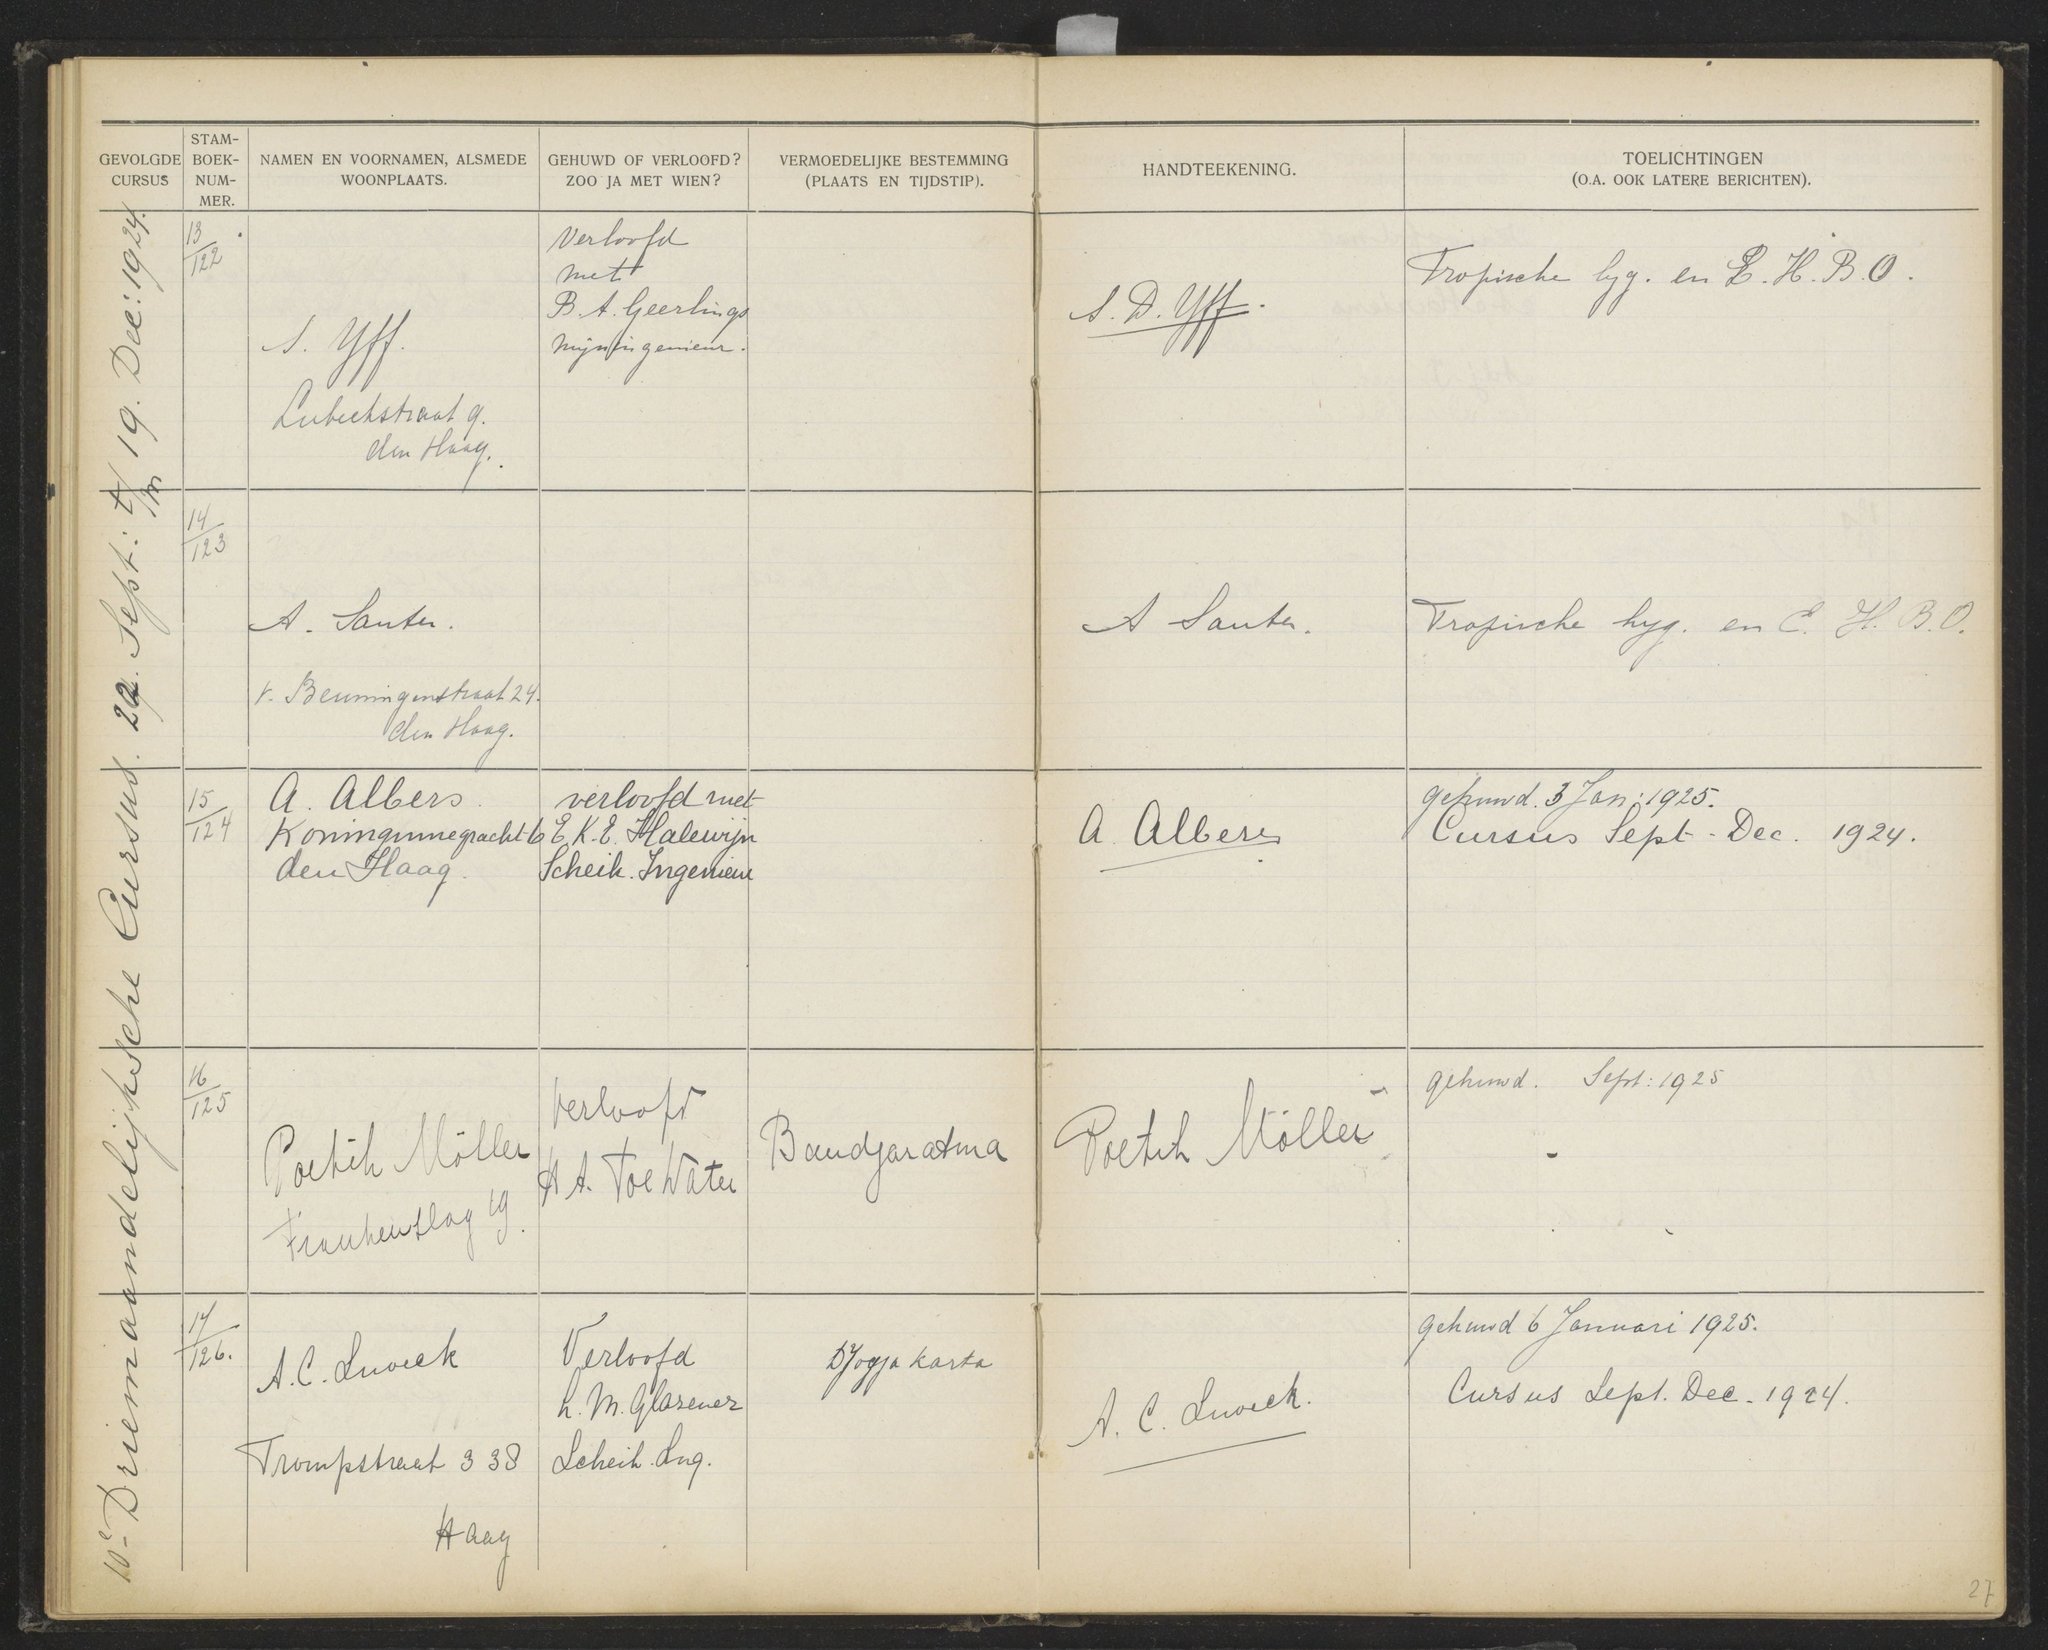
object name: album leaf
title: Blad 27 uit Stamboek van de leerlingen der Koloniale School voor Meisjes en Vrouwen te 's-Gravenhage deel I (1921-1929)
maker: Anonymous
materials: paper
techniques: printing, writing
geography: the hague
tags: further education (+ pupil), further education, the hague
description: Twee pagina's met gegevens van de deelnemers aan de 10e driemaandelijkse cursus van 22 september tot en met 19 december 1924, stamboeknummers 122 tot en met 126. Onderdeel van Stamboek van de leerlingen der Koloniale School voor Meisjes en Vrouwen te 's-Gravenhage deel I (1921-1929).